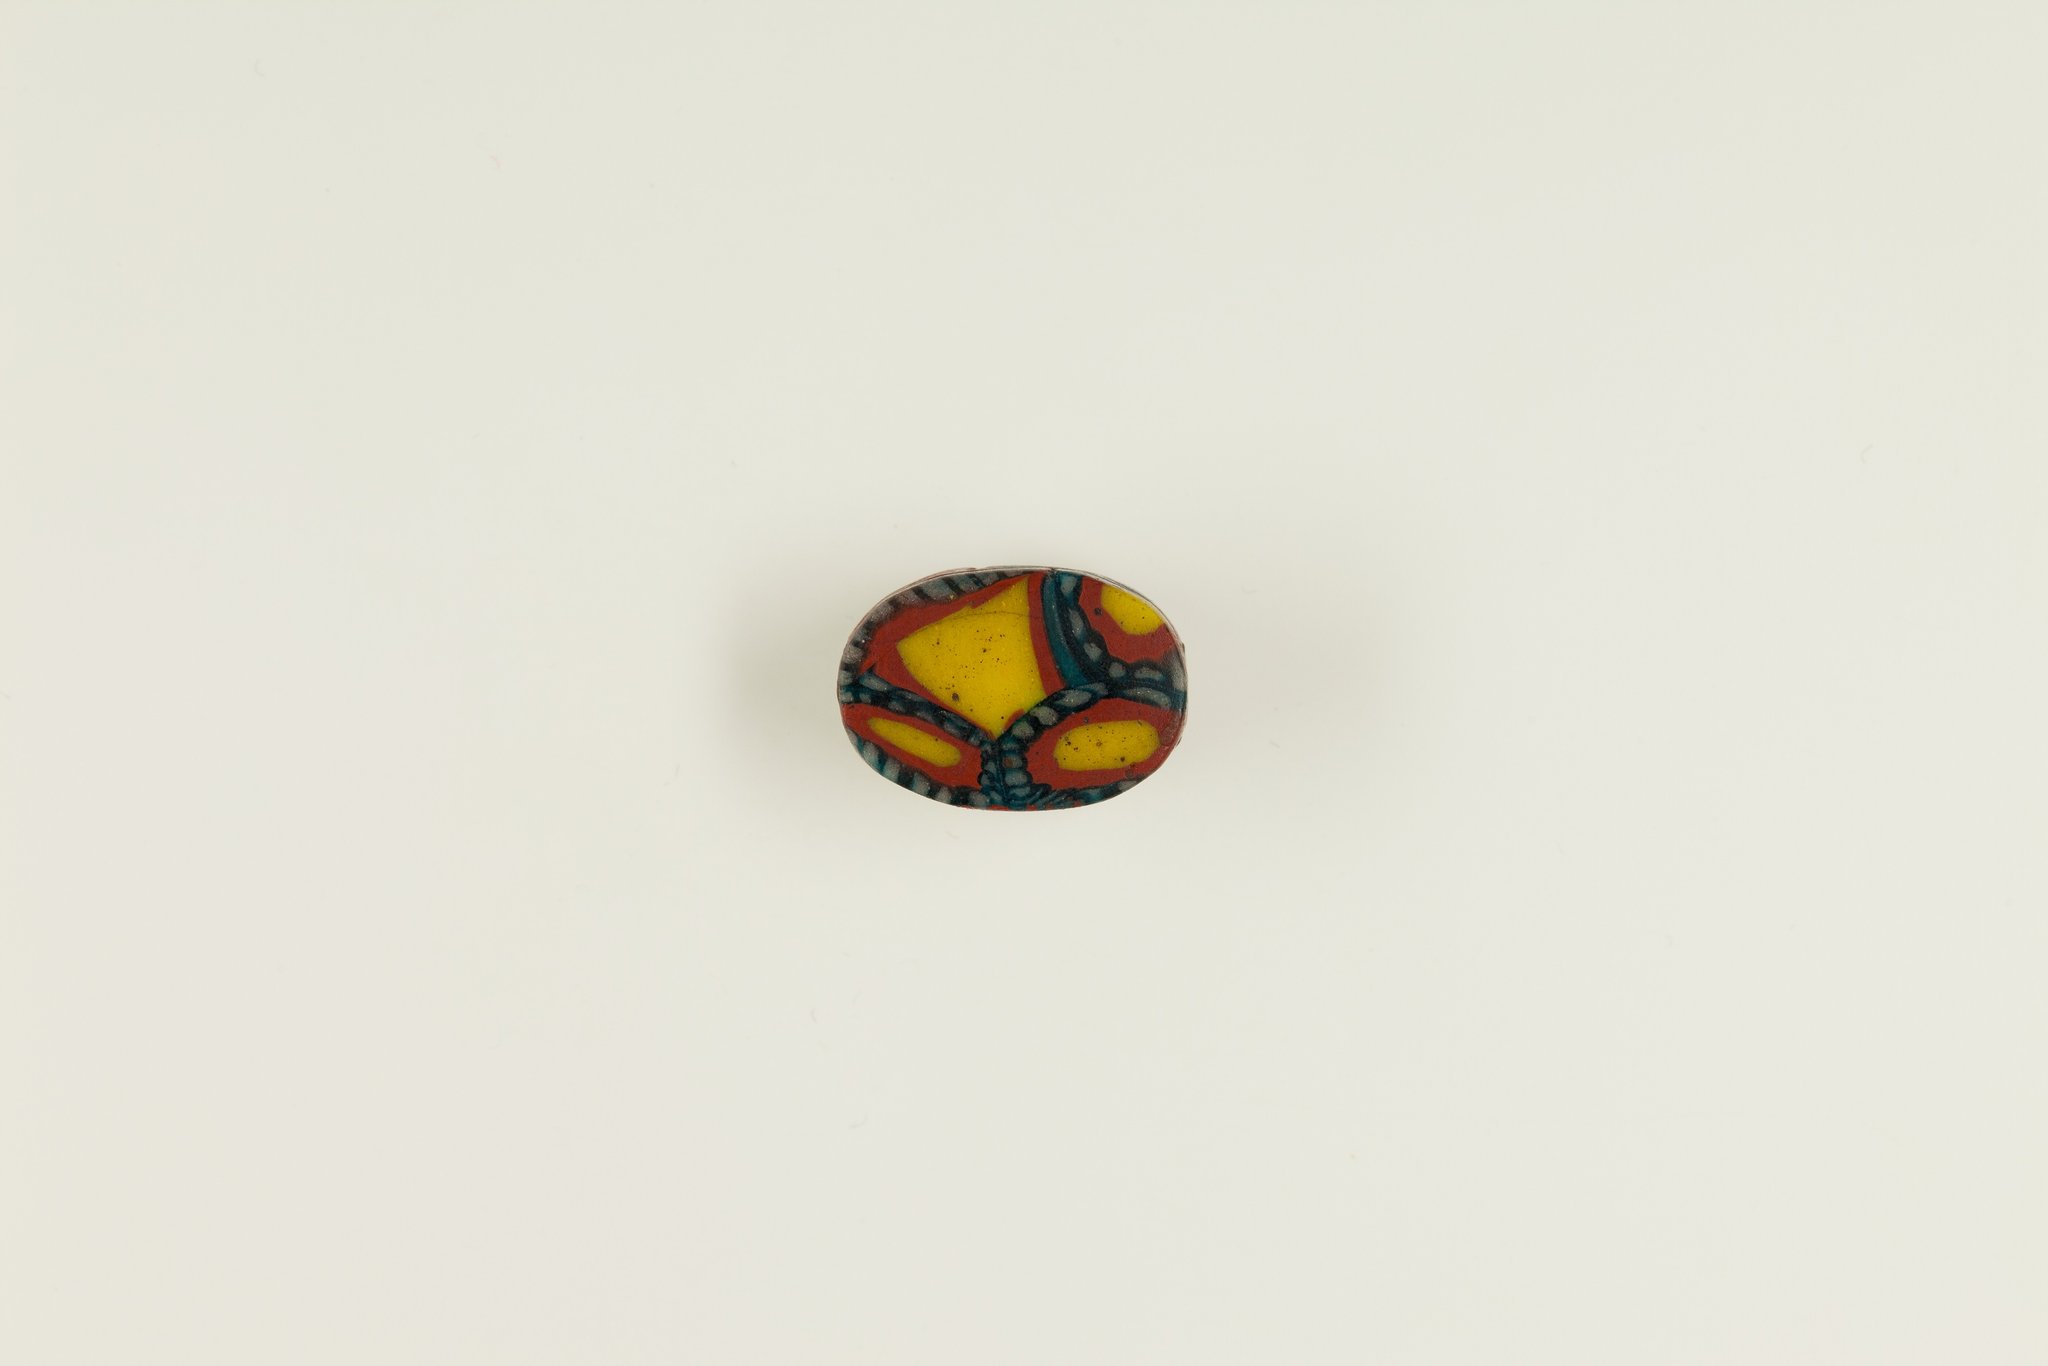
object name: scarab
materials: glass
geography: egypt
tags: scarabs